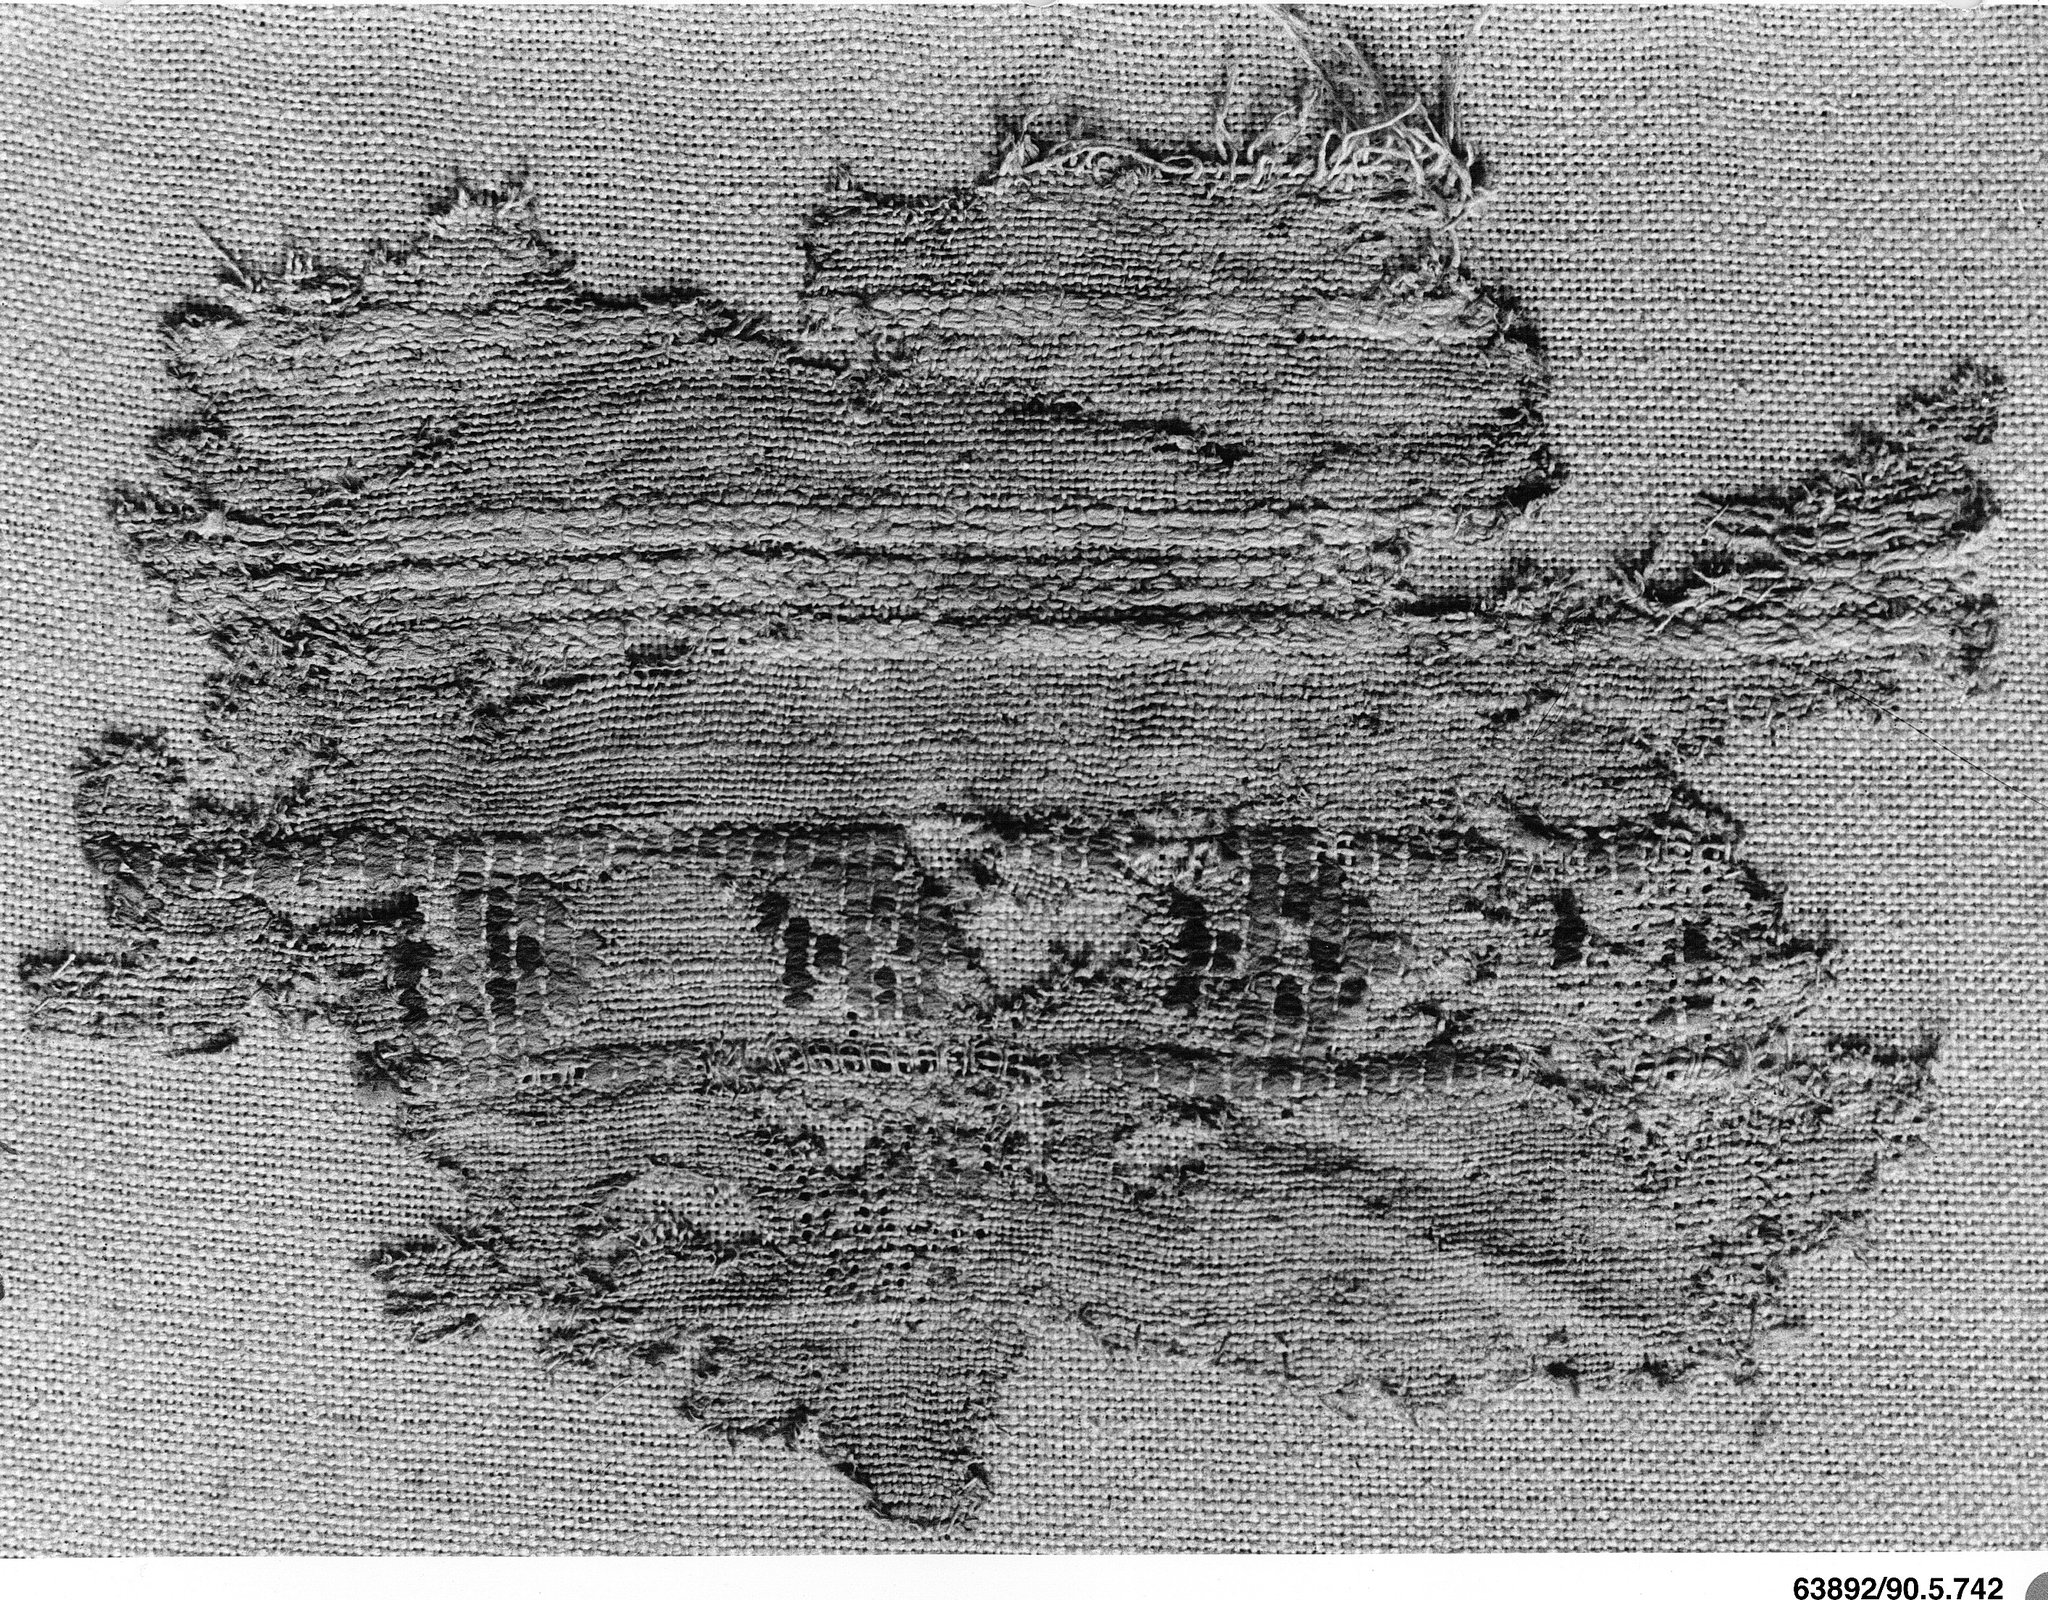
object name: textile fragment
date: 401-600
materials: linen, wool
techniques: brocade, weave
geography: egypt